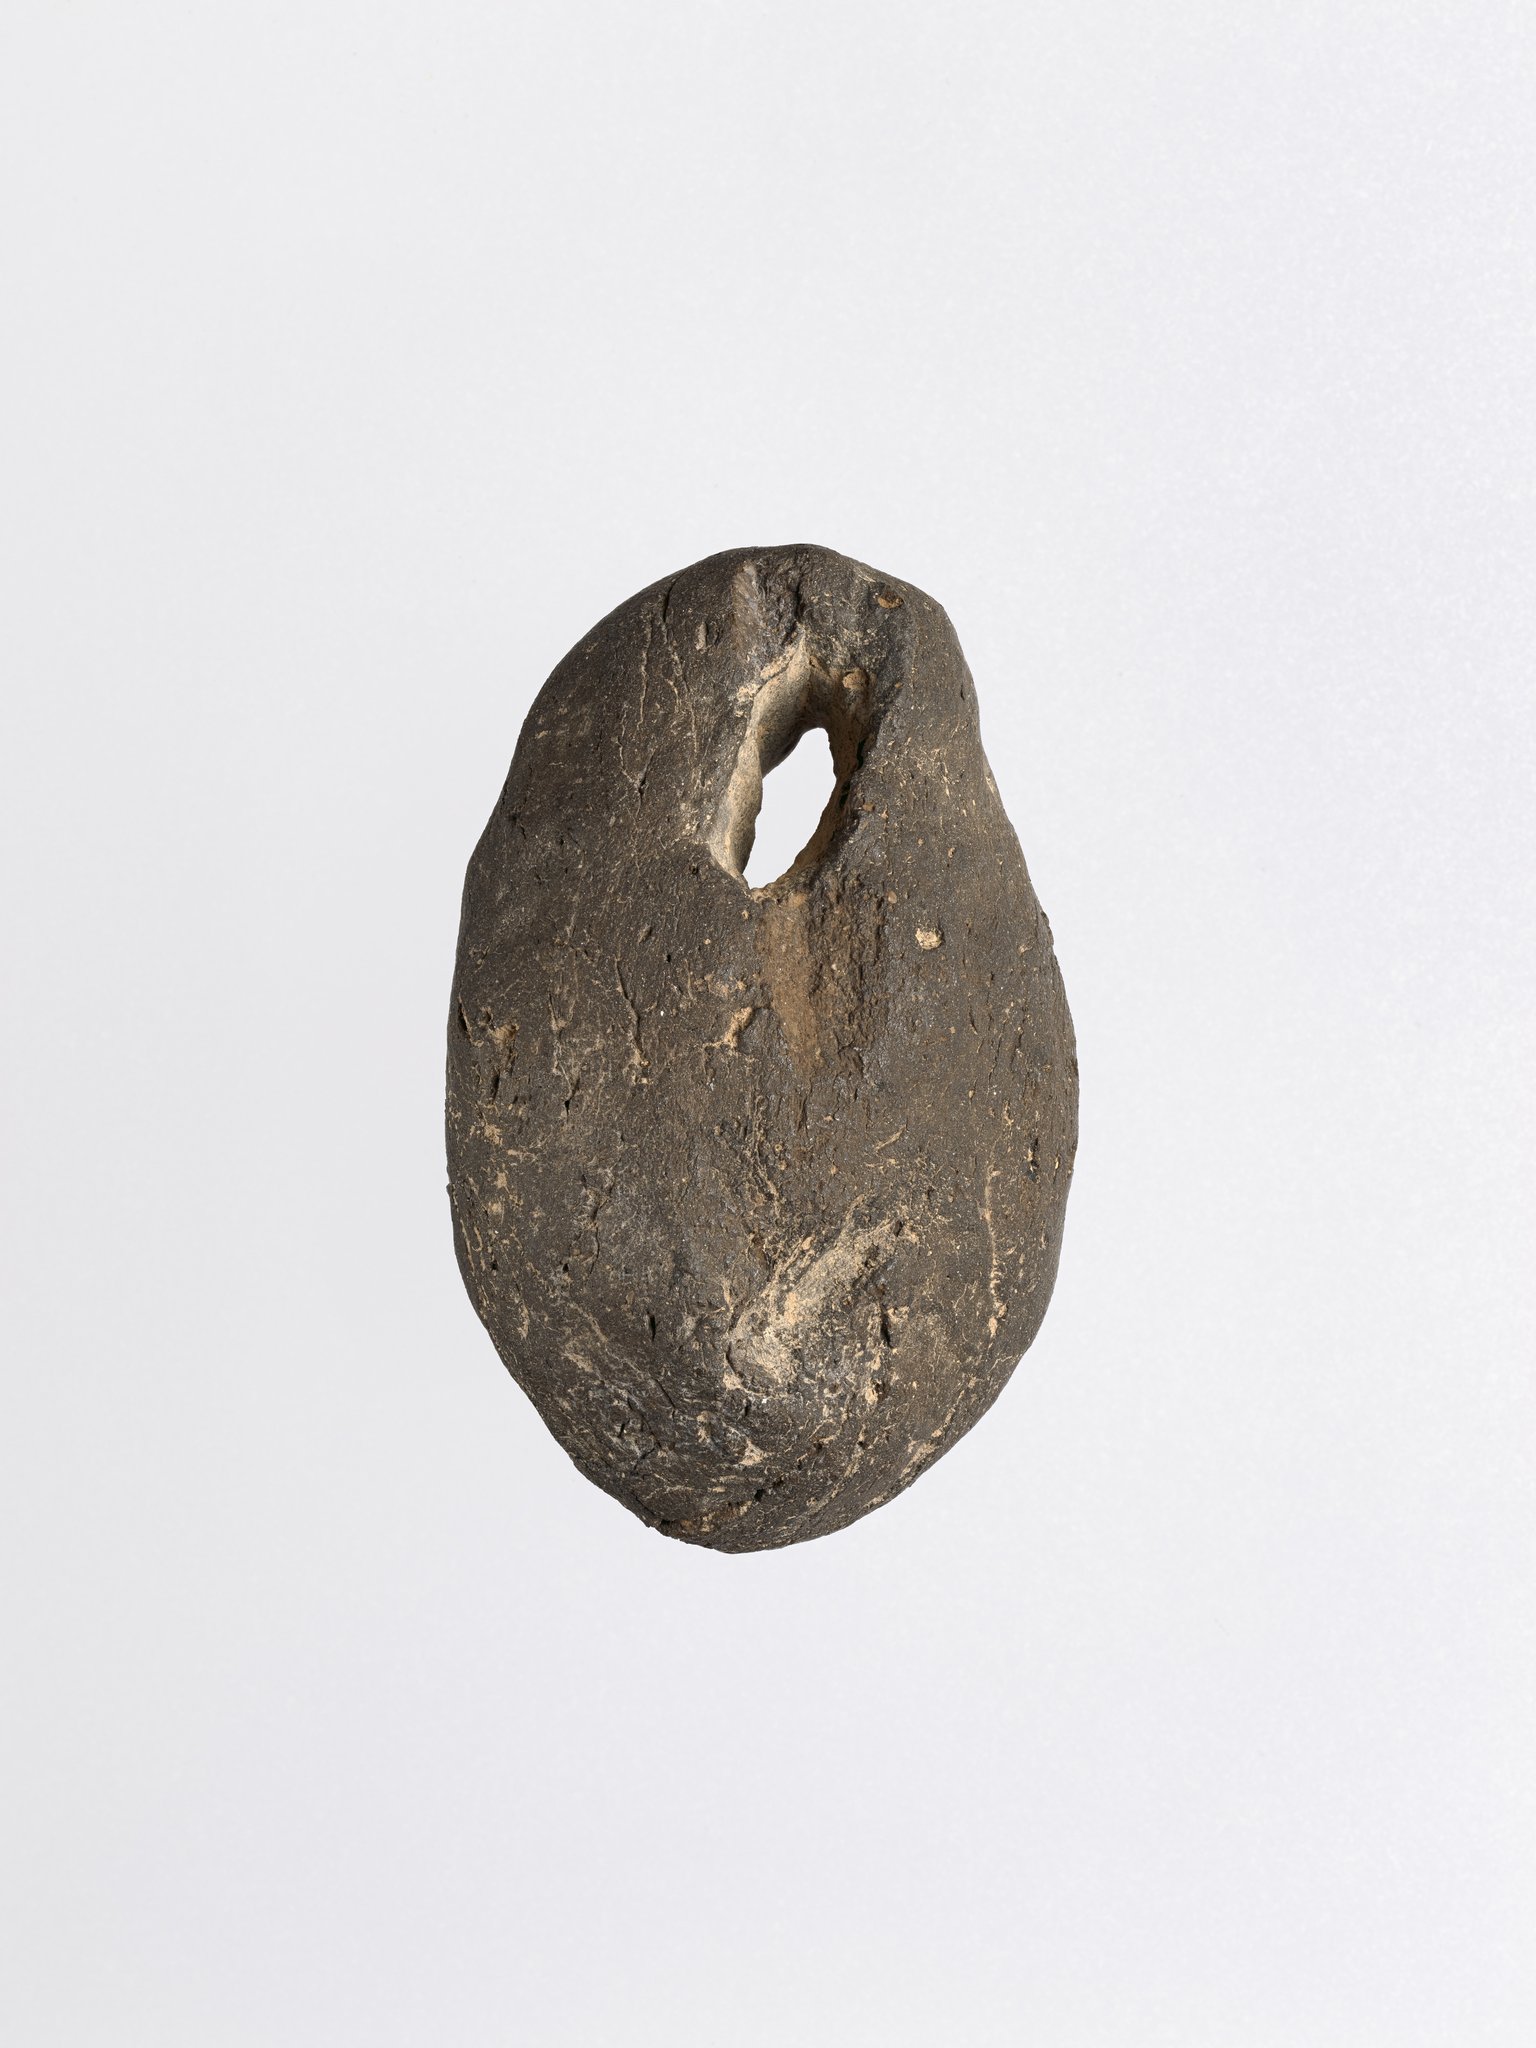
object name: weight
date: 3100-2900 BCE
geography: mesopotamia